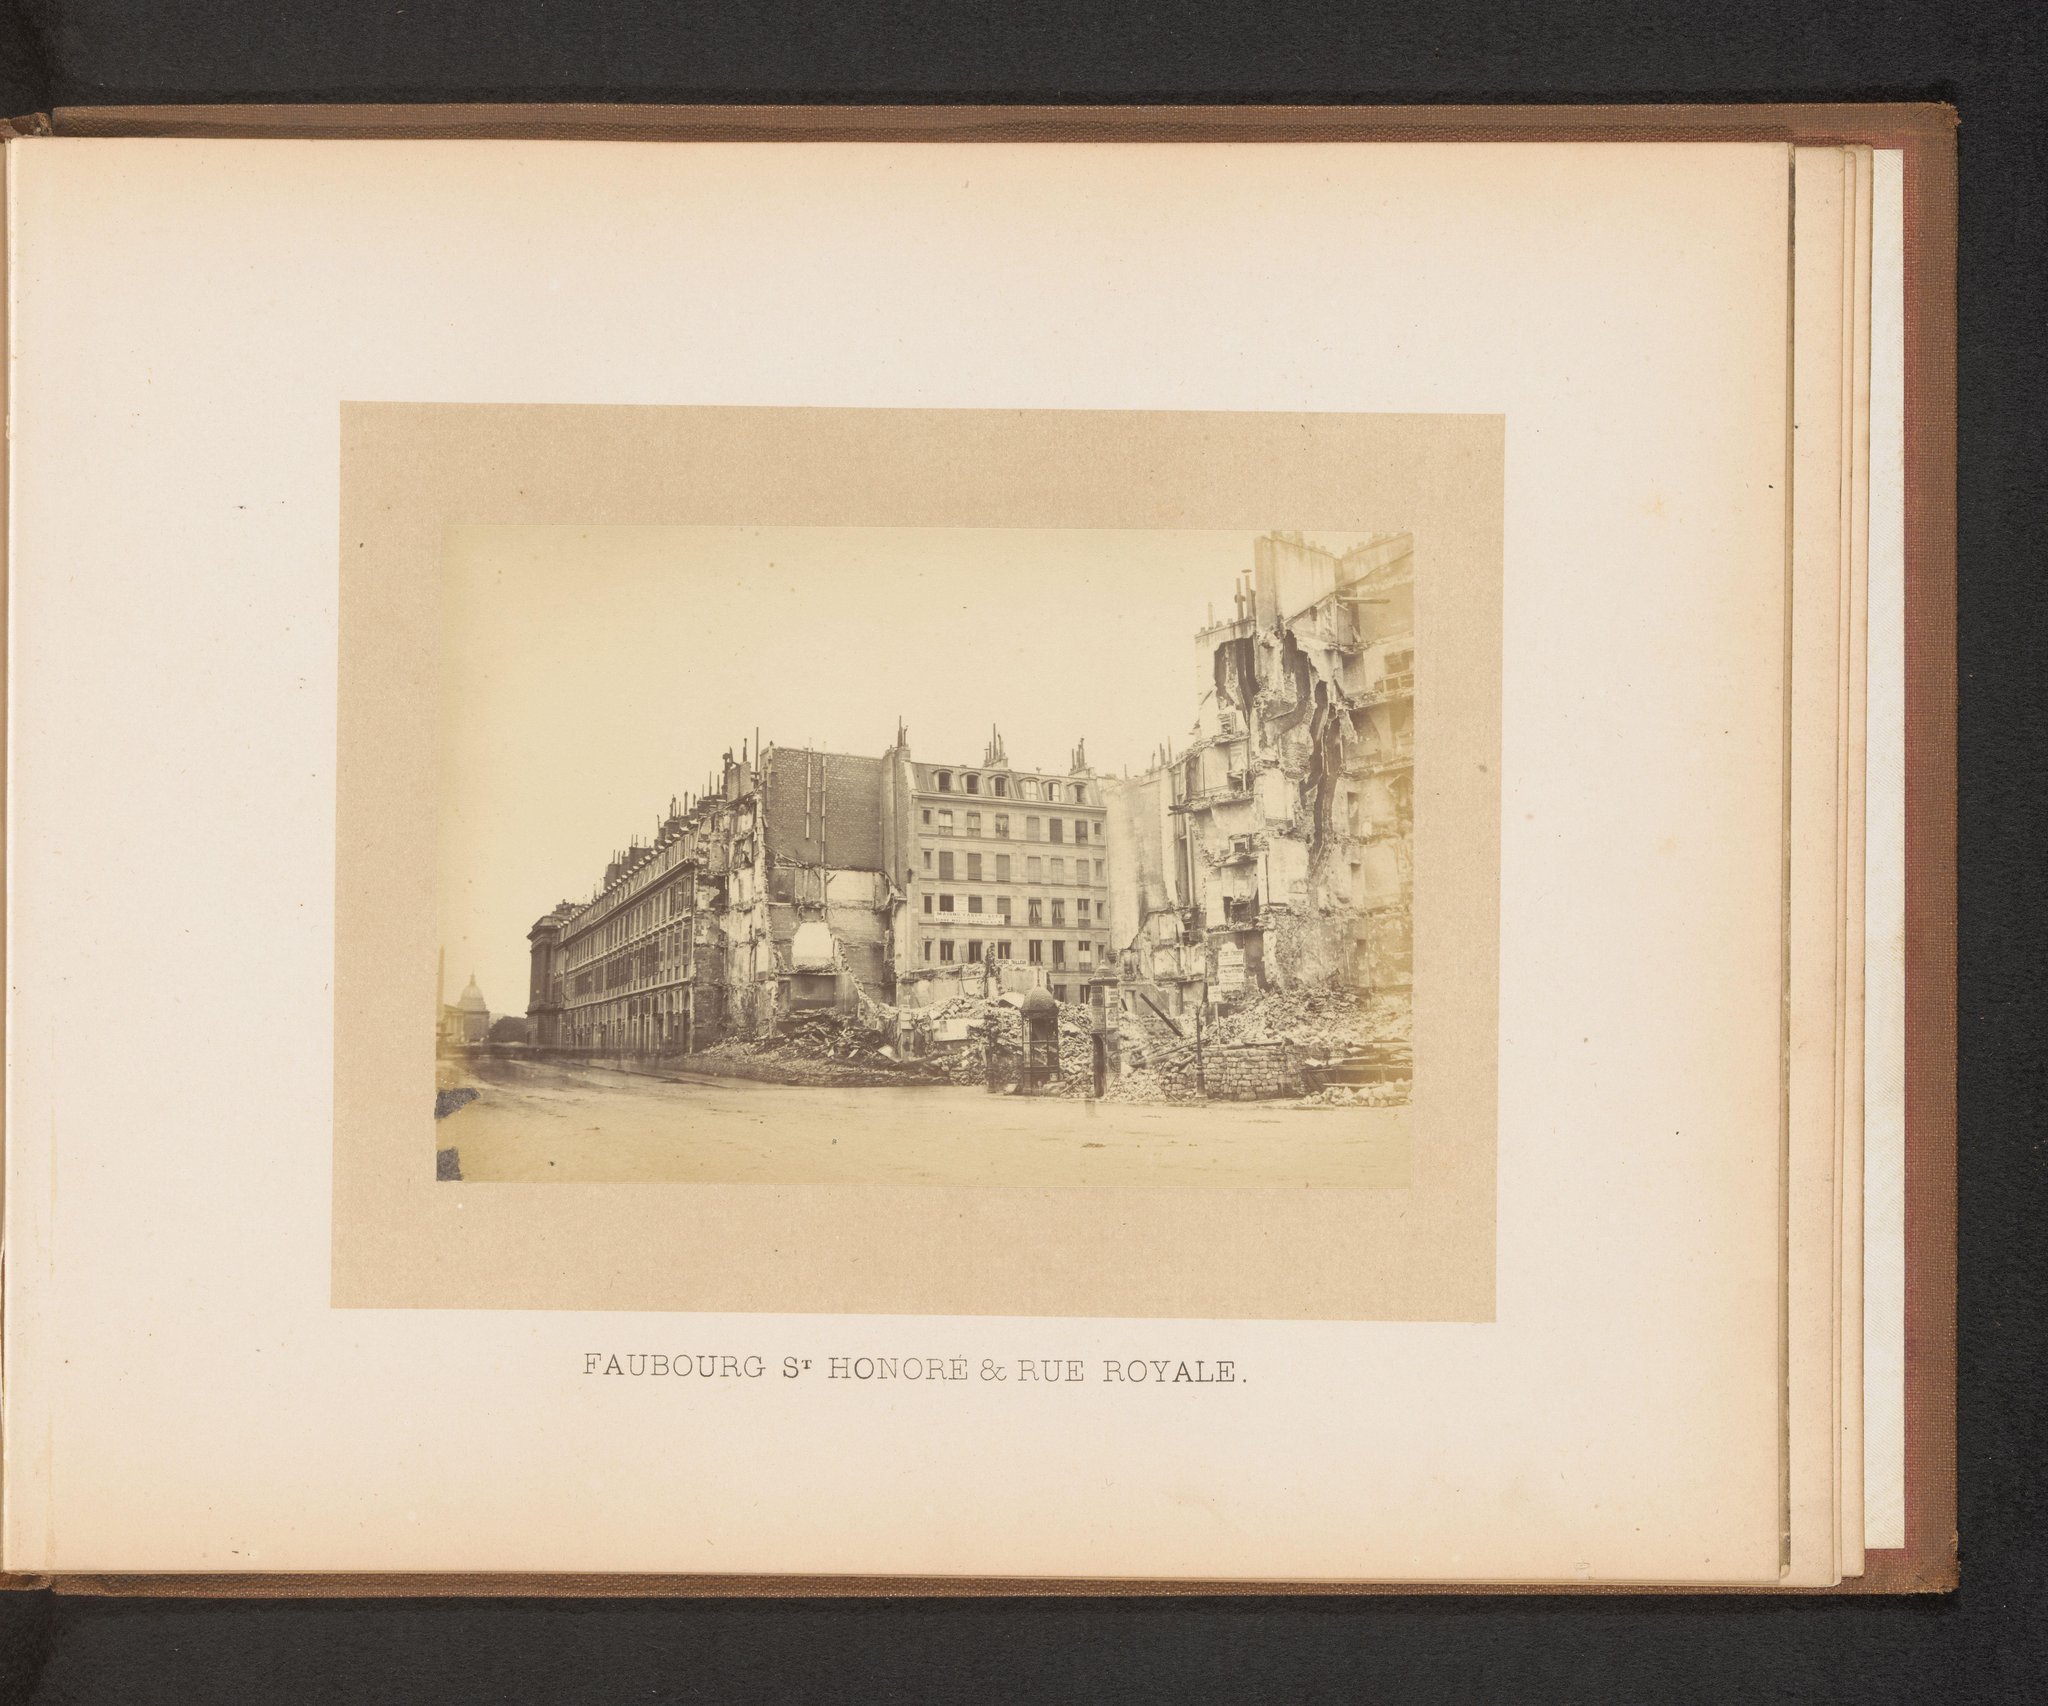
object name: page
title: Fabourg St Honoré & Rue Royale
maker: Anonymous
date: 1871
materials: photographic support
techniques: albumen print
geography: paris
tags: theatre (building), street